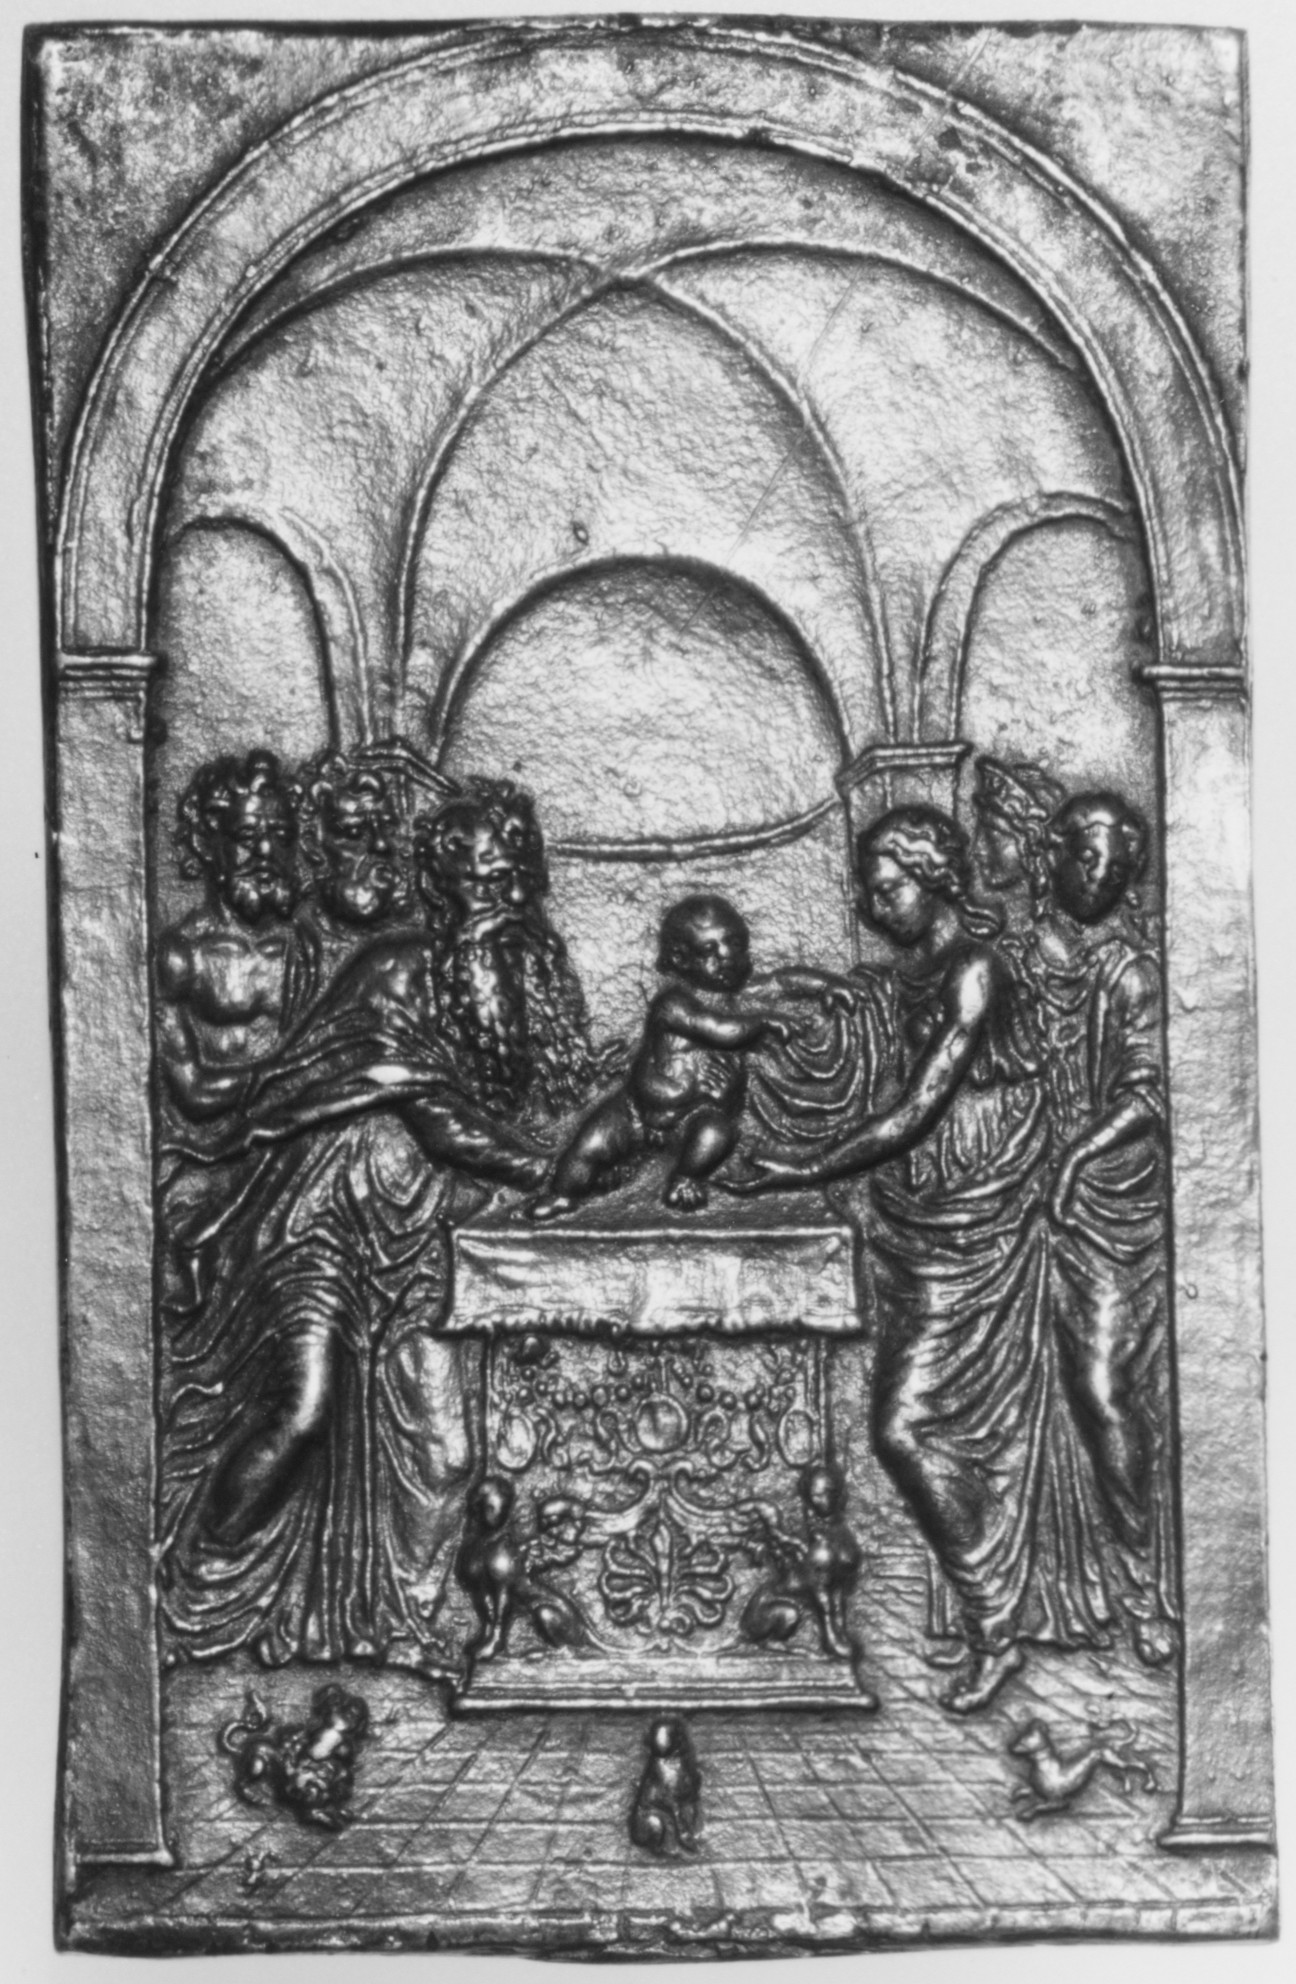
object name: plaquette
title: The Presentation of Christ in the Temple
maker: moderno (galeazzo mondella)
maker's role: artist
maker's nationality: italian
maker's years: 1467-1528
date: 1467-1533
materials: bronze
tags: animals,temples,men,jesus